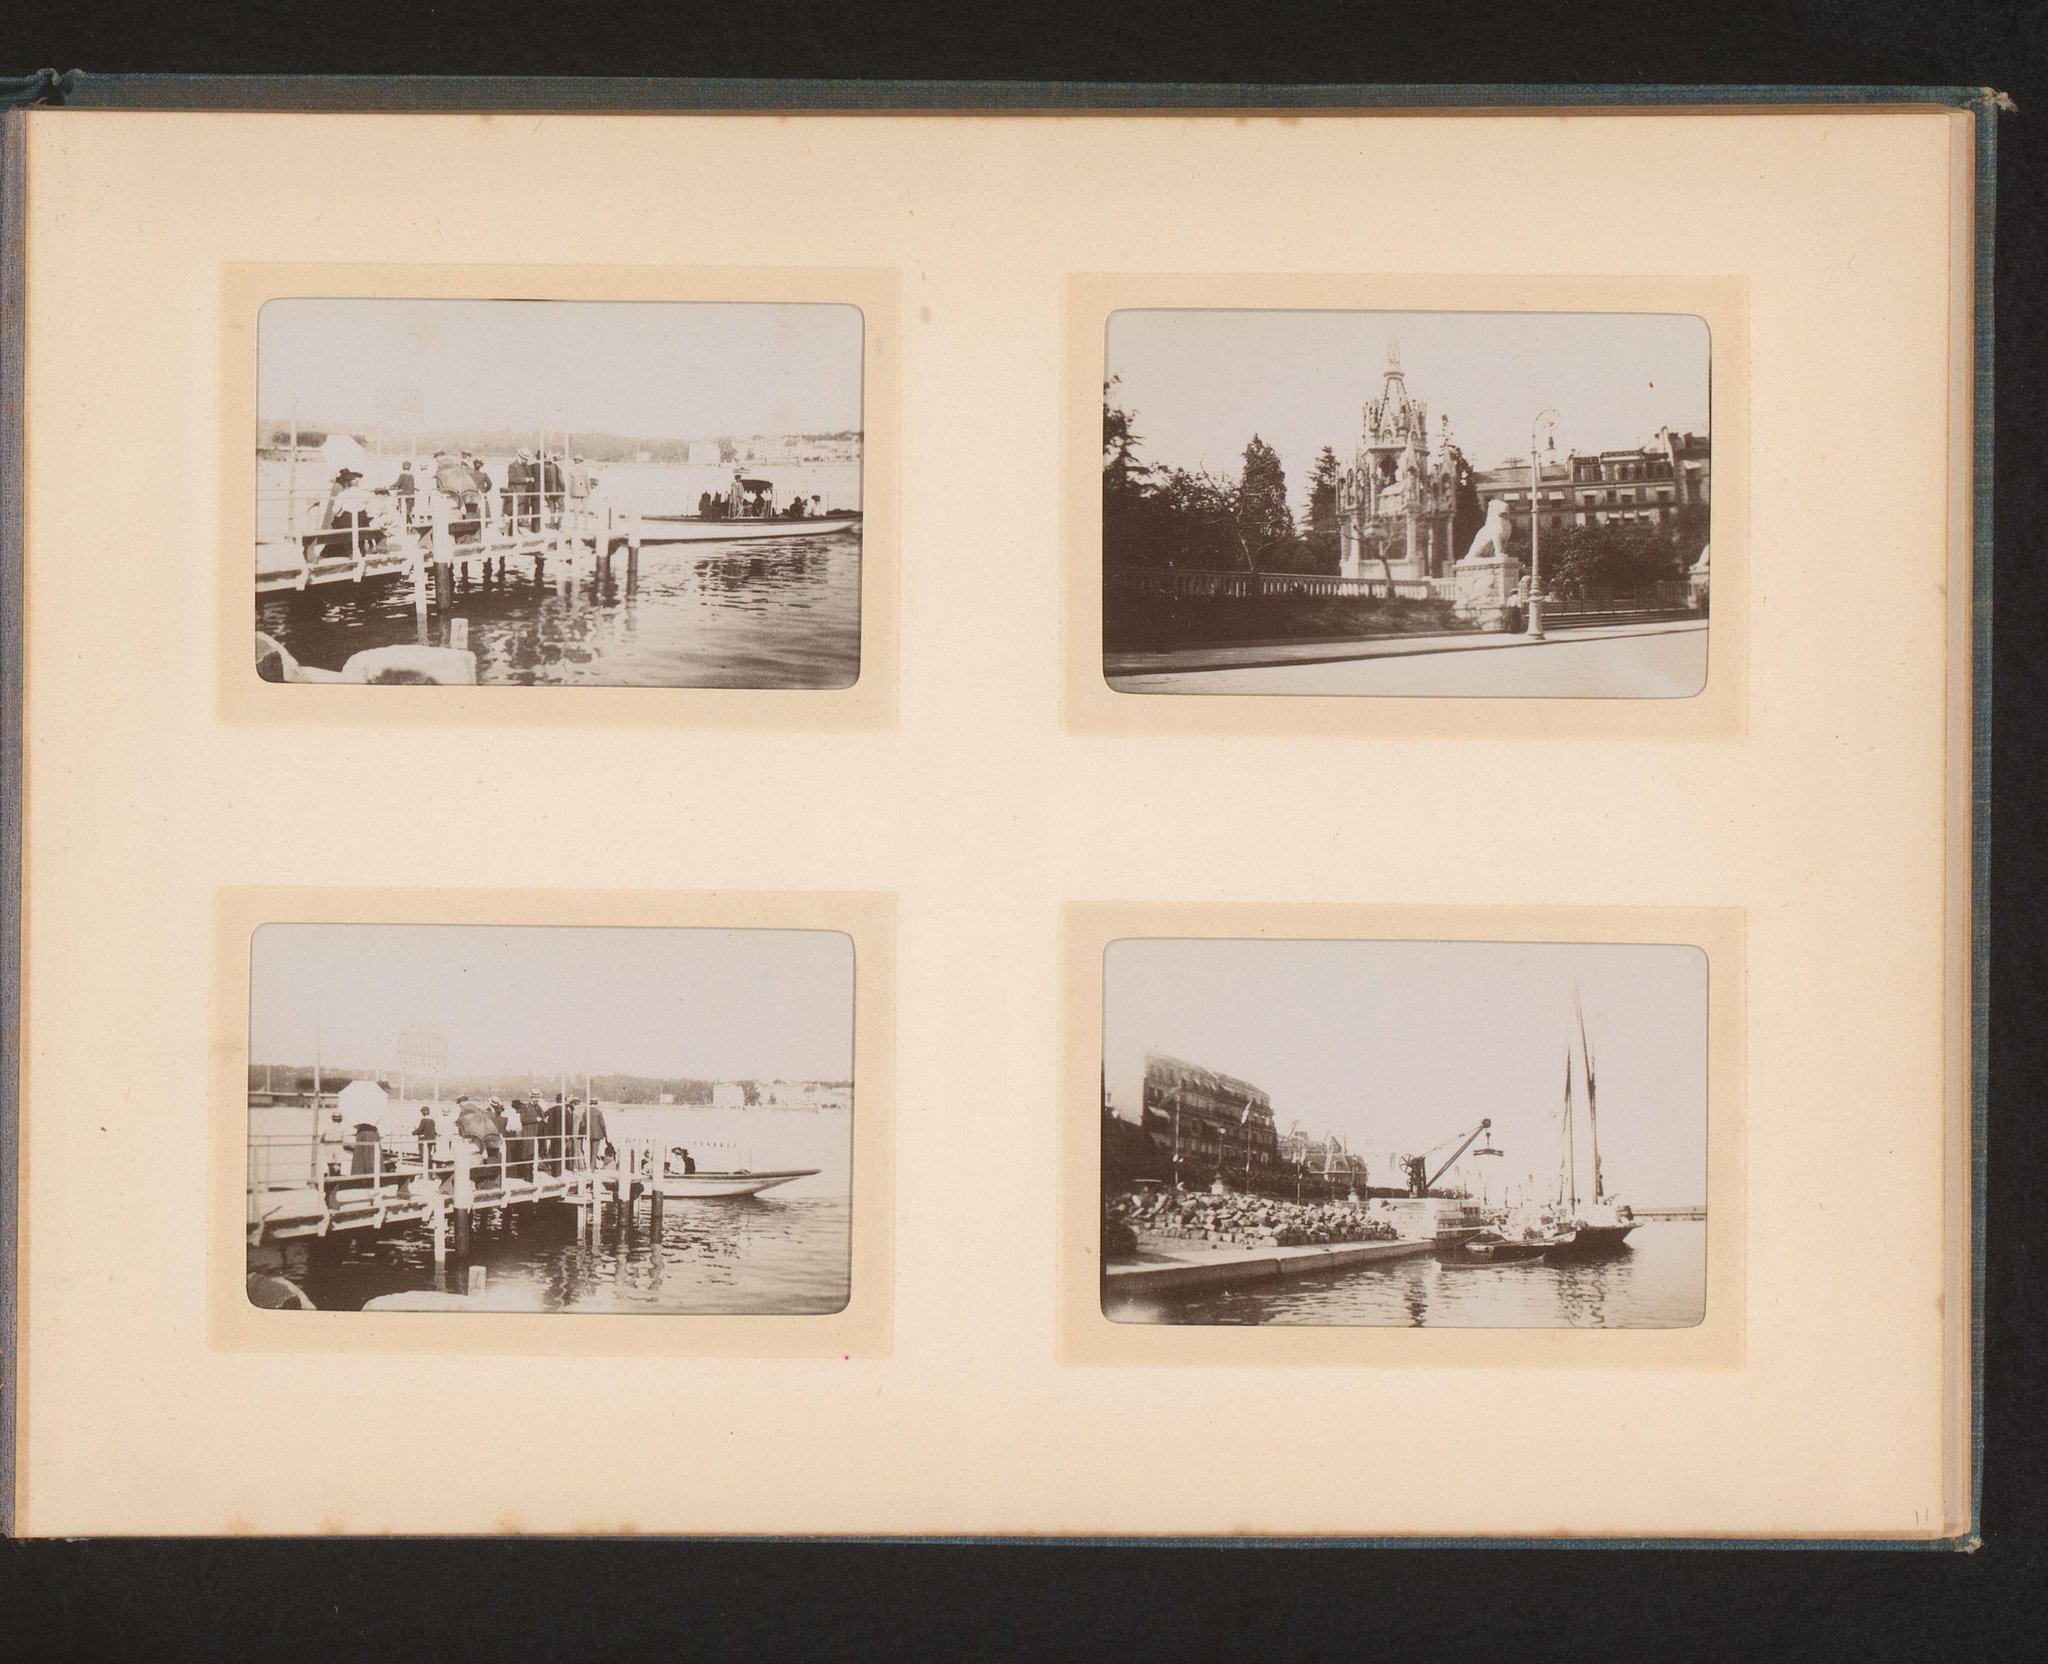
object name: photograph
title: Drie landschappen met water te Frankrijk en Gezicht op een bouwwerk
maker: Anonymous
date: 1900-1915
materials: paper, photographic support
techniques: gelatin silver print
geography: france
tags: landscapes with waters, waterscapes, seascapes (in the temperate zone), ships (in general), travelling; tourism, civic architecture; edifices; dwellings, france